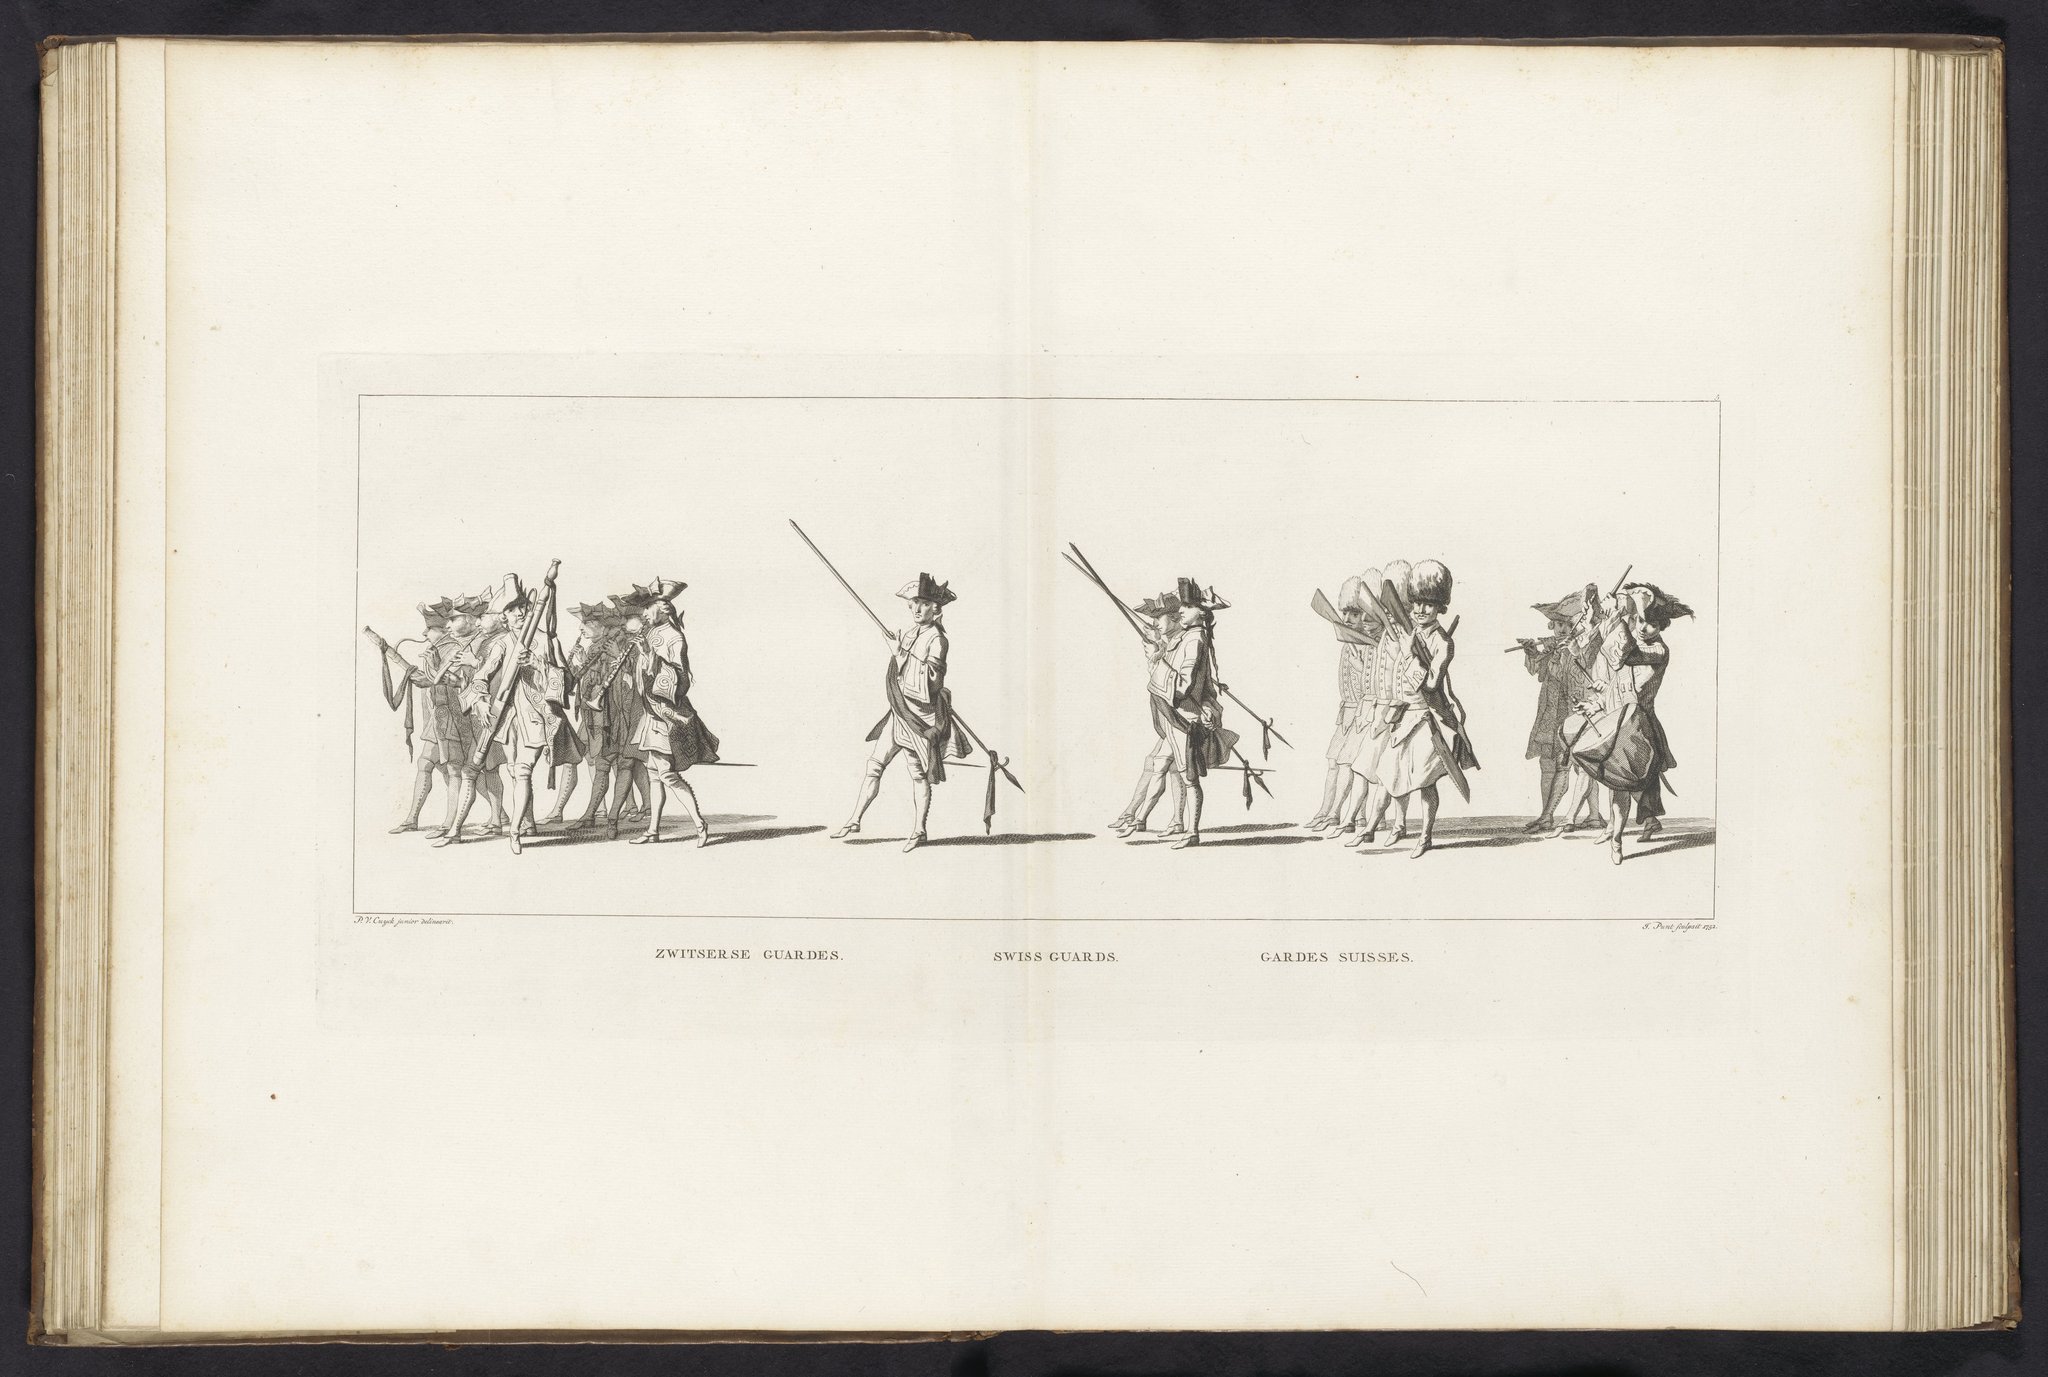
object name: print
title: Zwitserse Guardes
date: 1752-1755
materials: paper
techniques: engraving, etching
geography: the hague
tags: willem iv (prins van oranje-nassau), military parade, pageant (+ infantry), military music, cortege, funeral procession, delft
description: De Zwitserse Garde, met muzikanten. In de marge het onderschrift in Nederlands, Frans en Engels. Onderdeel van een serie van 41 platen van de begrafenisstoet van stadhouder Willem IV te Delft op 4 februari 1752. Genummerd rechtsboven: 5. In de gebonden uitgave van 1755.